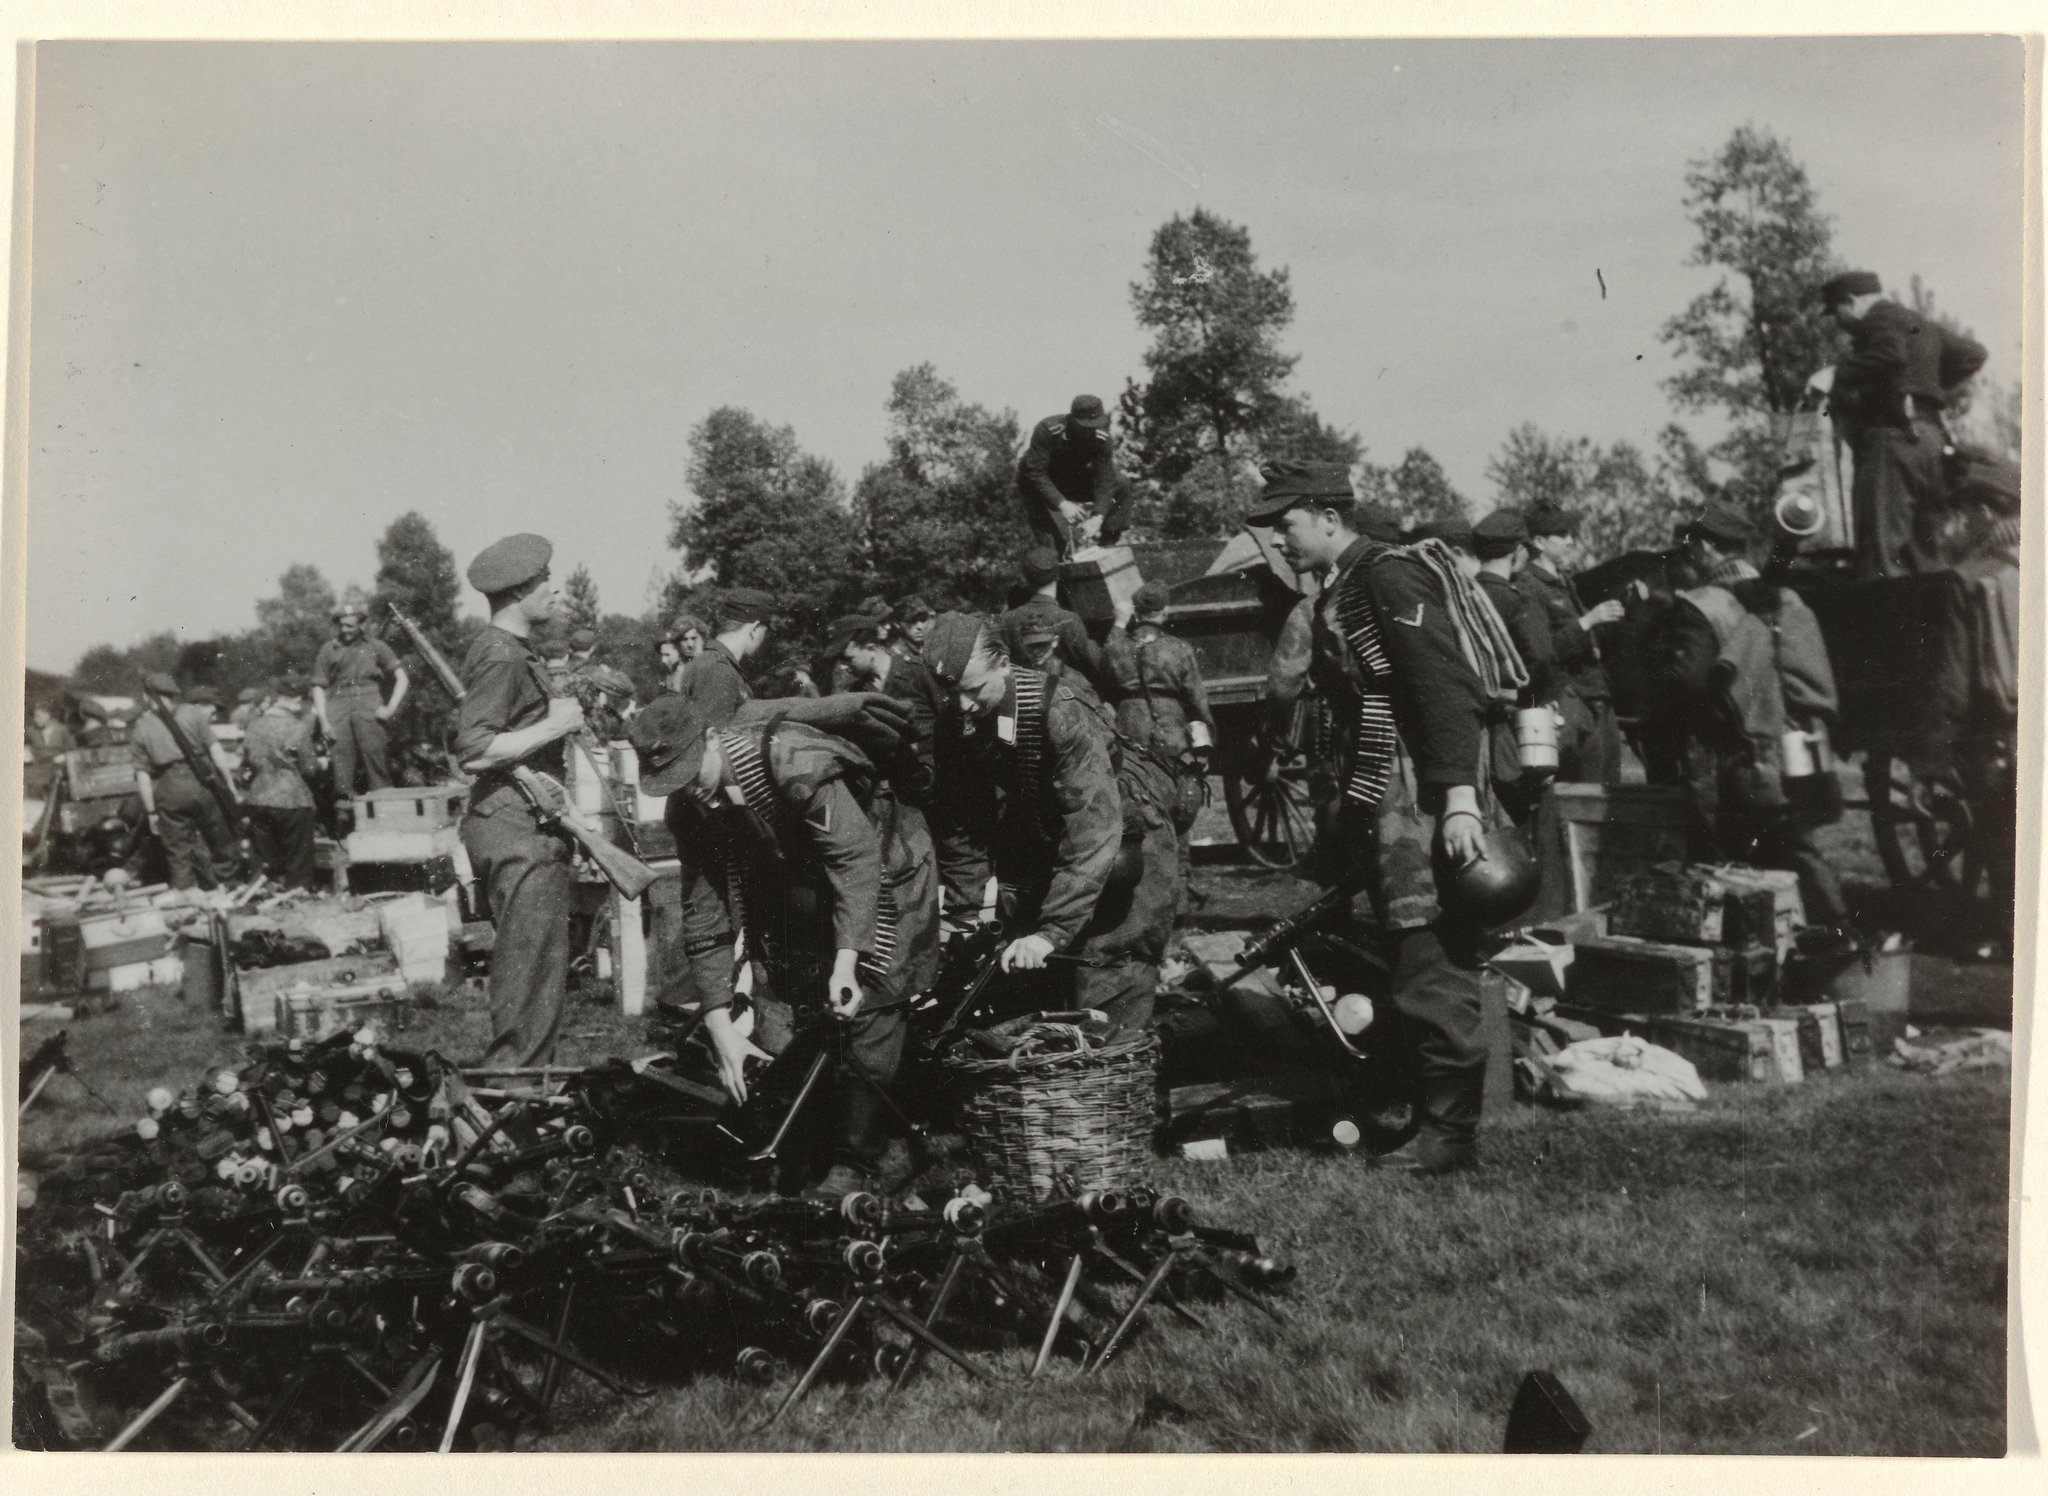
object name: documentary photograph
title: Inlevering van wapens door Duitse soldaten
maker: willem van de poll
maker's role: fotograaf, journalist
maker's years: 1895-1970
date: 1905-1945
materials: photographic support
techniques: photography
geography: soest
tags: soest (utrecht), bevrijding van nederland (1945)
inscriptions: number: ‘3056’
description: Na de Duitse capitulatie moeten de Duitse soldaten hun wapens inleveren. Op achterzijde foto opschrift: "In 't kamp Soest is het een drukte van belang. Van alle kanten komen Duitsers hun wapens inleveren".